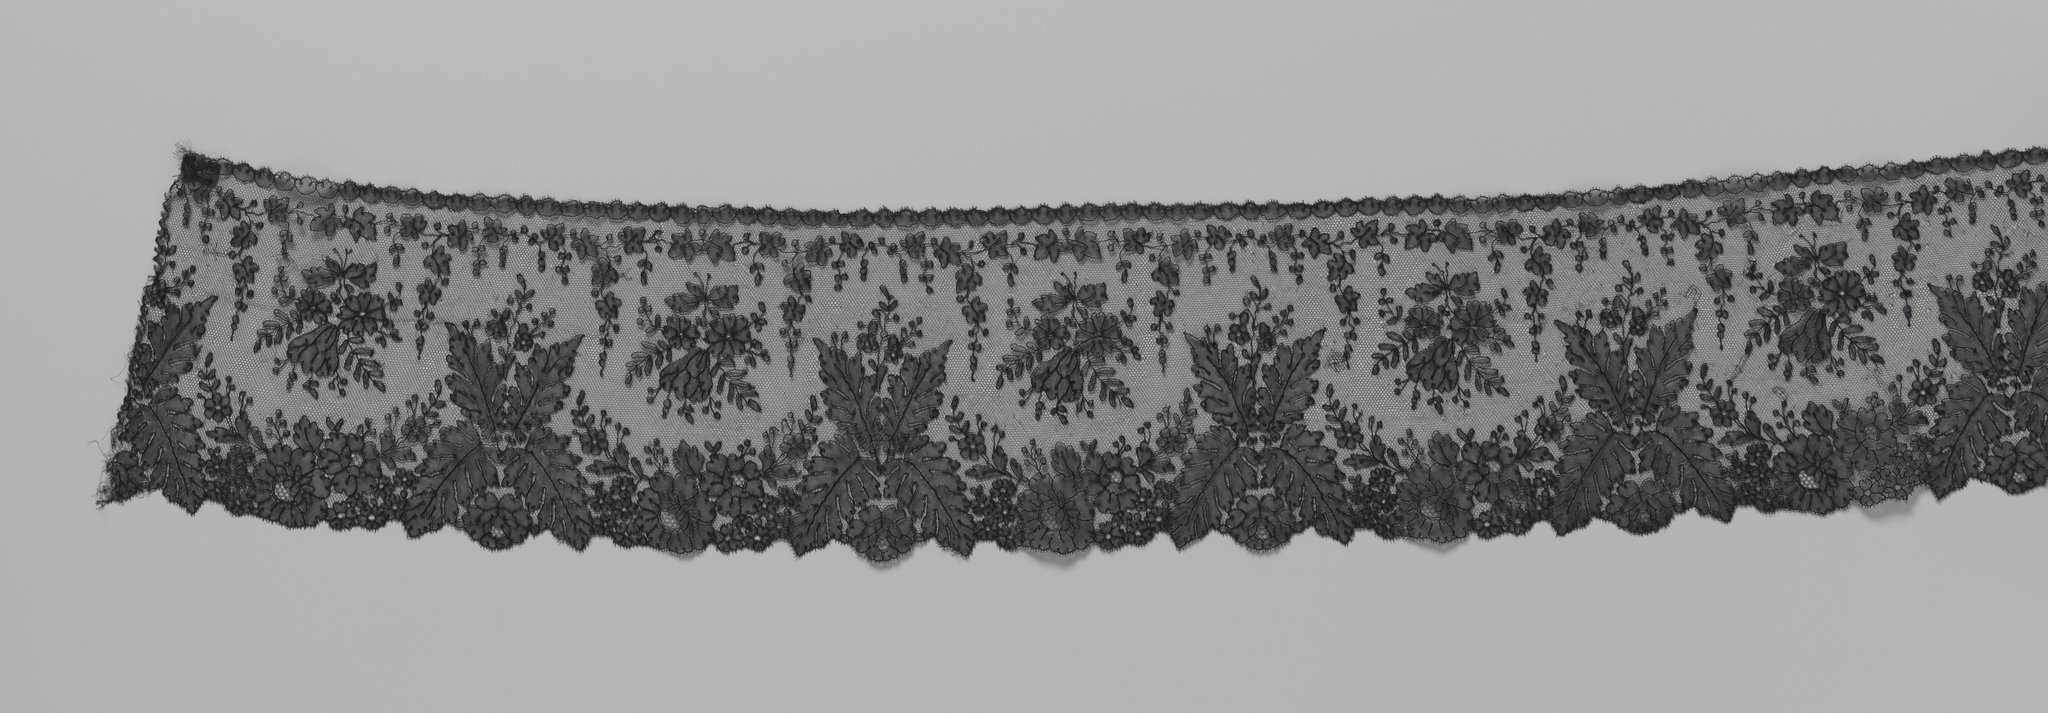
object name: strip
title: Japonstrook van kloskant met varens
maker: Anonymous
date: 1850-1855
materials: silk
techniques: lace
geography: france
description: Japonstrook van zwarte kloskant: Chantilly-kant. Op een leeg mazenfond staat een gesloten rand met schulpen, gevuld met een guirlande van bloemen en bladeren. Op de snijpunten staat een kleine schulp met een hangende roos, waarboven een spits boeket oprijst van vier grote varenbladeren en een bloemtak, die tot aan de bovenrand reikt. Hier loopt een horizontale klimoprank met hangende takjes, terwijl op het veld boven de grote schulp van deze klimoprank een groot boeket afhangt, onder andere met een tulp.